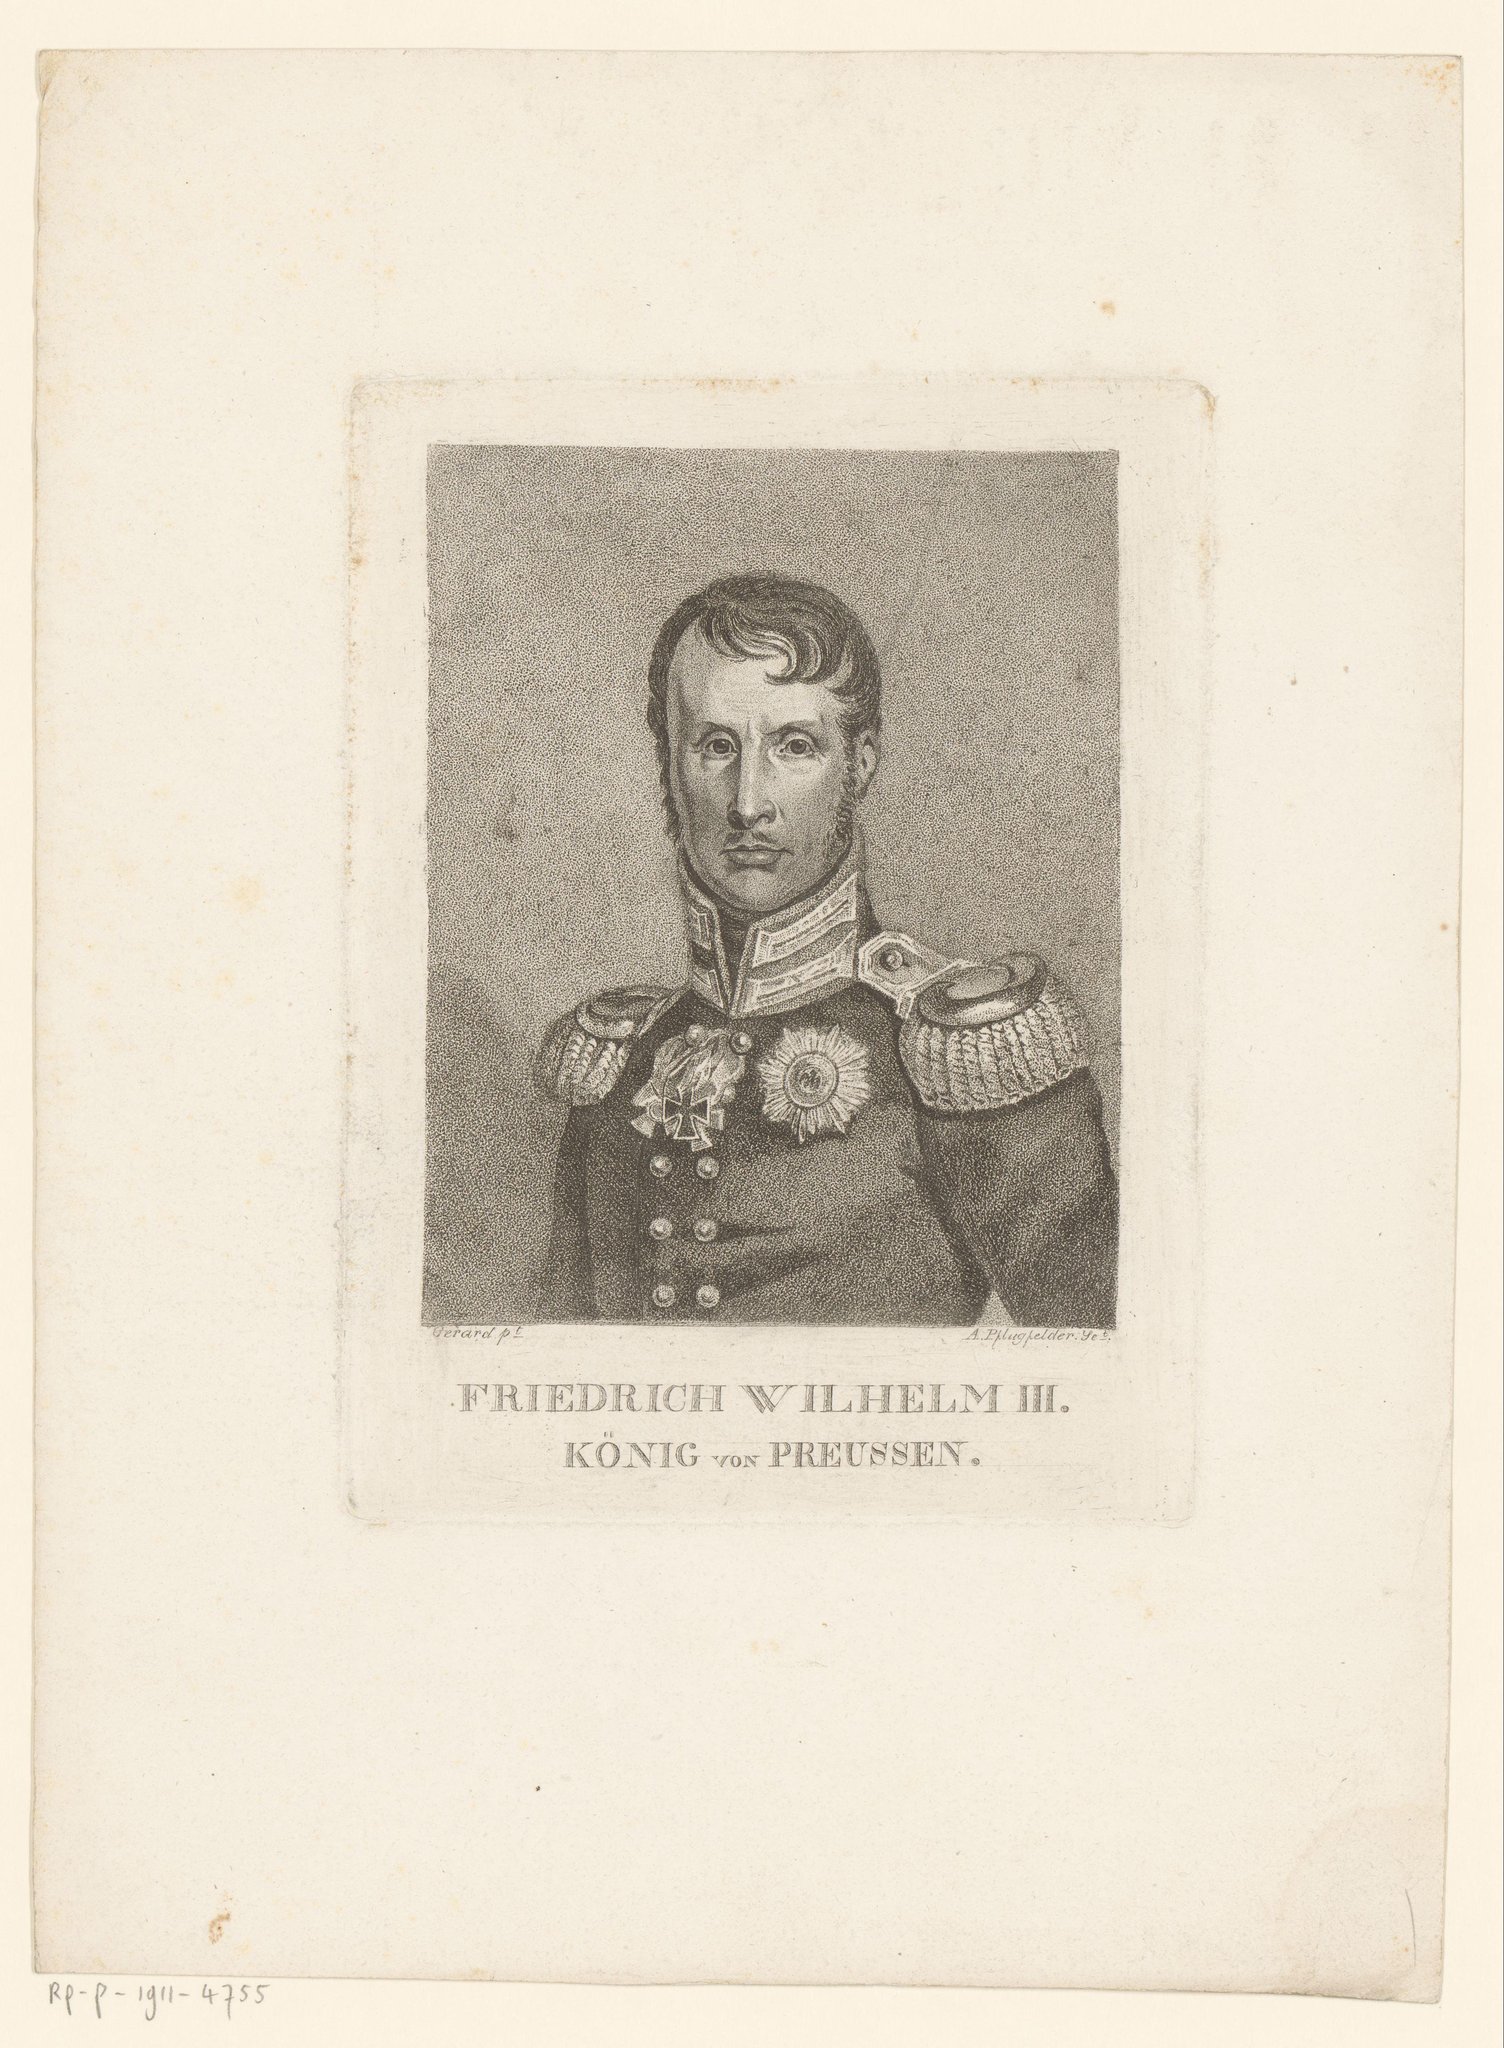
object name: print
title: Portret van Friedrich Wilhelm III van Pruisen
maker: friedrich august pflugfelder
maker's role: print maker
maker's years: 1809-1856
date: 1819-1911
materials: paper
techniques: stippled etching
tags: berlin, frederik willem iii koning van pruisen, historical persons, medals and other marks of military honour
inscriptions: collector's mark: Lugt 2228